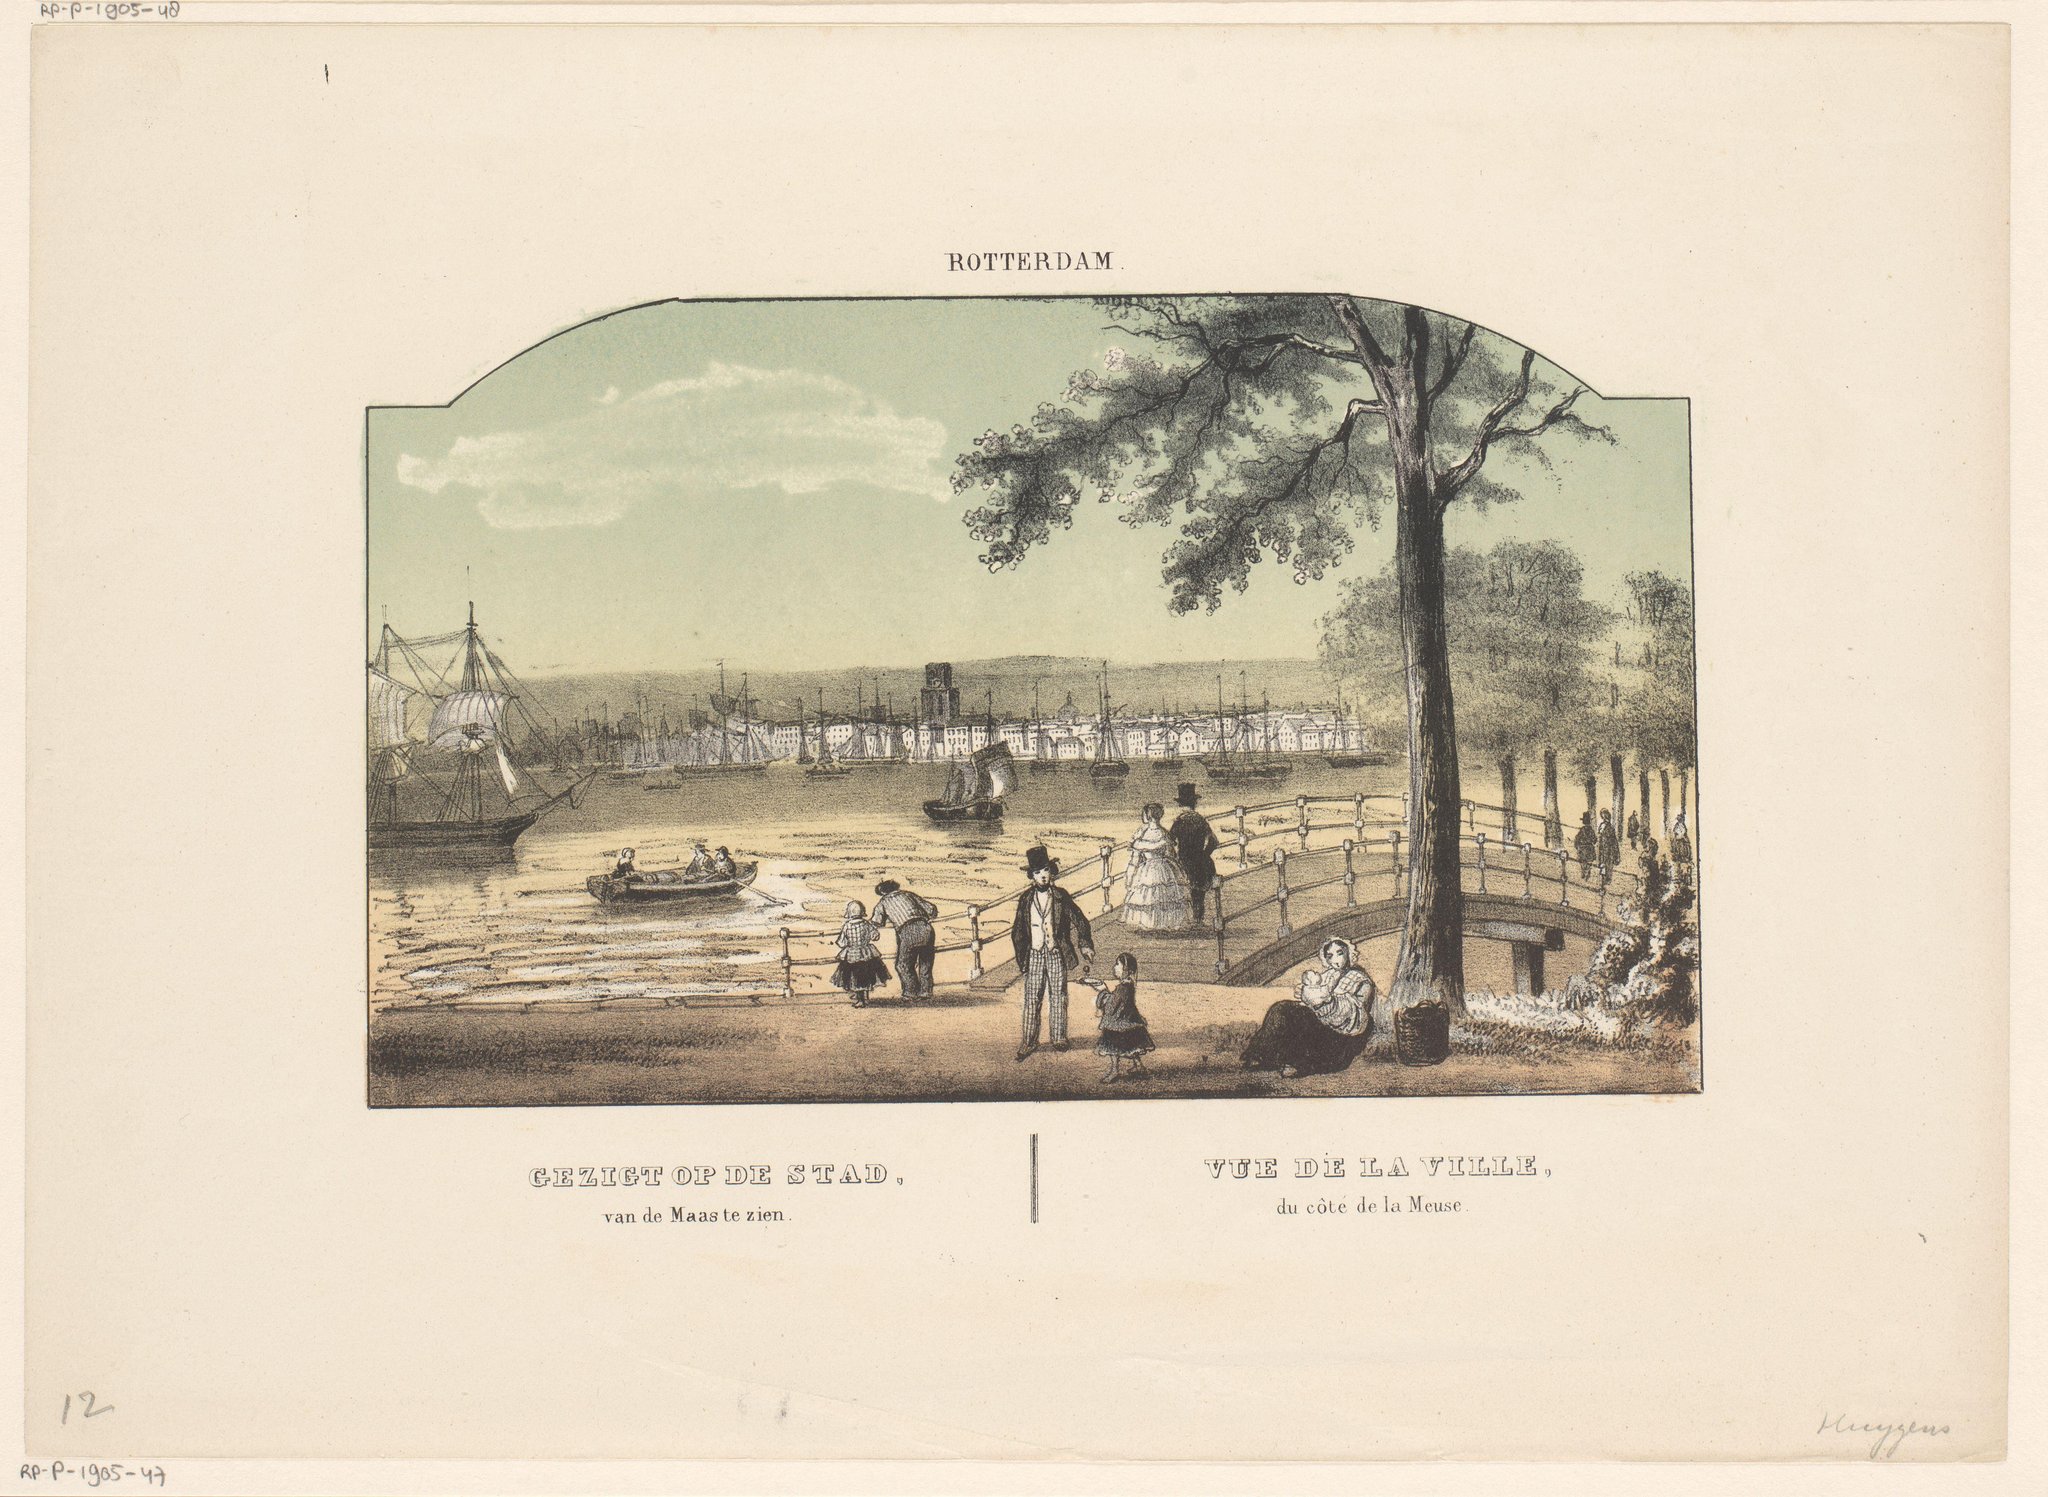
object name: print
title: Rotterdam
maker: frederik lodewijk huygens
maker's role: draughtsman, print maker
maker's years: 1802-1887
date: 1812-1887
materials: paper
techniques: iris print, lithograph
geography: netherlands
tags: city-view, and landscape with man-made constructions (+ city(-scape) with figures, staffage), prospect of city, town panorama, silhouette of city (+ city(-scape) with figures, staffage), rotterdam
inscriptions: collector's mark: Lugt 2228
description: Maakte deel uit van een serie over Rotterdam, zie RP-P-1905-46 t/m RP-P-1905-53. Nummer RP-P-1905-46 hiervan is gesigneerd.